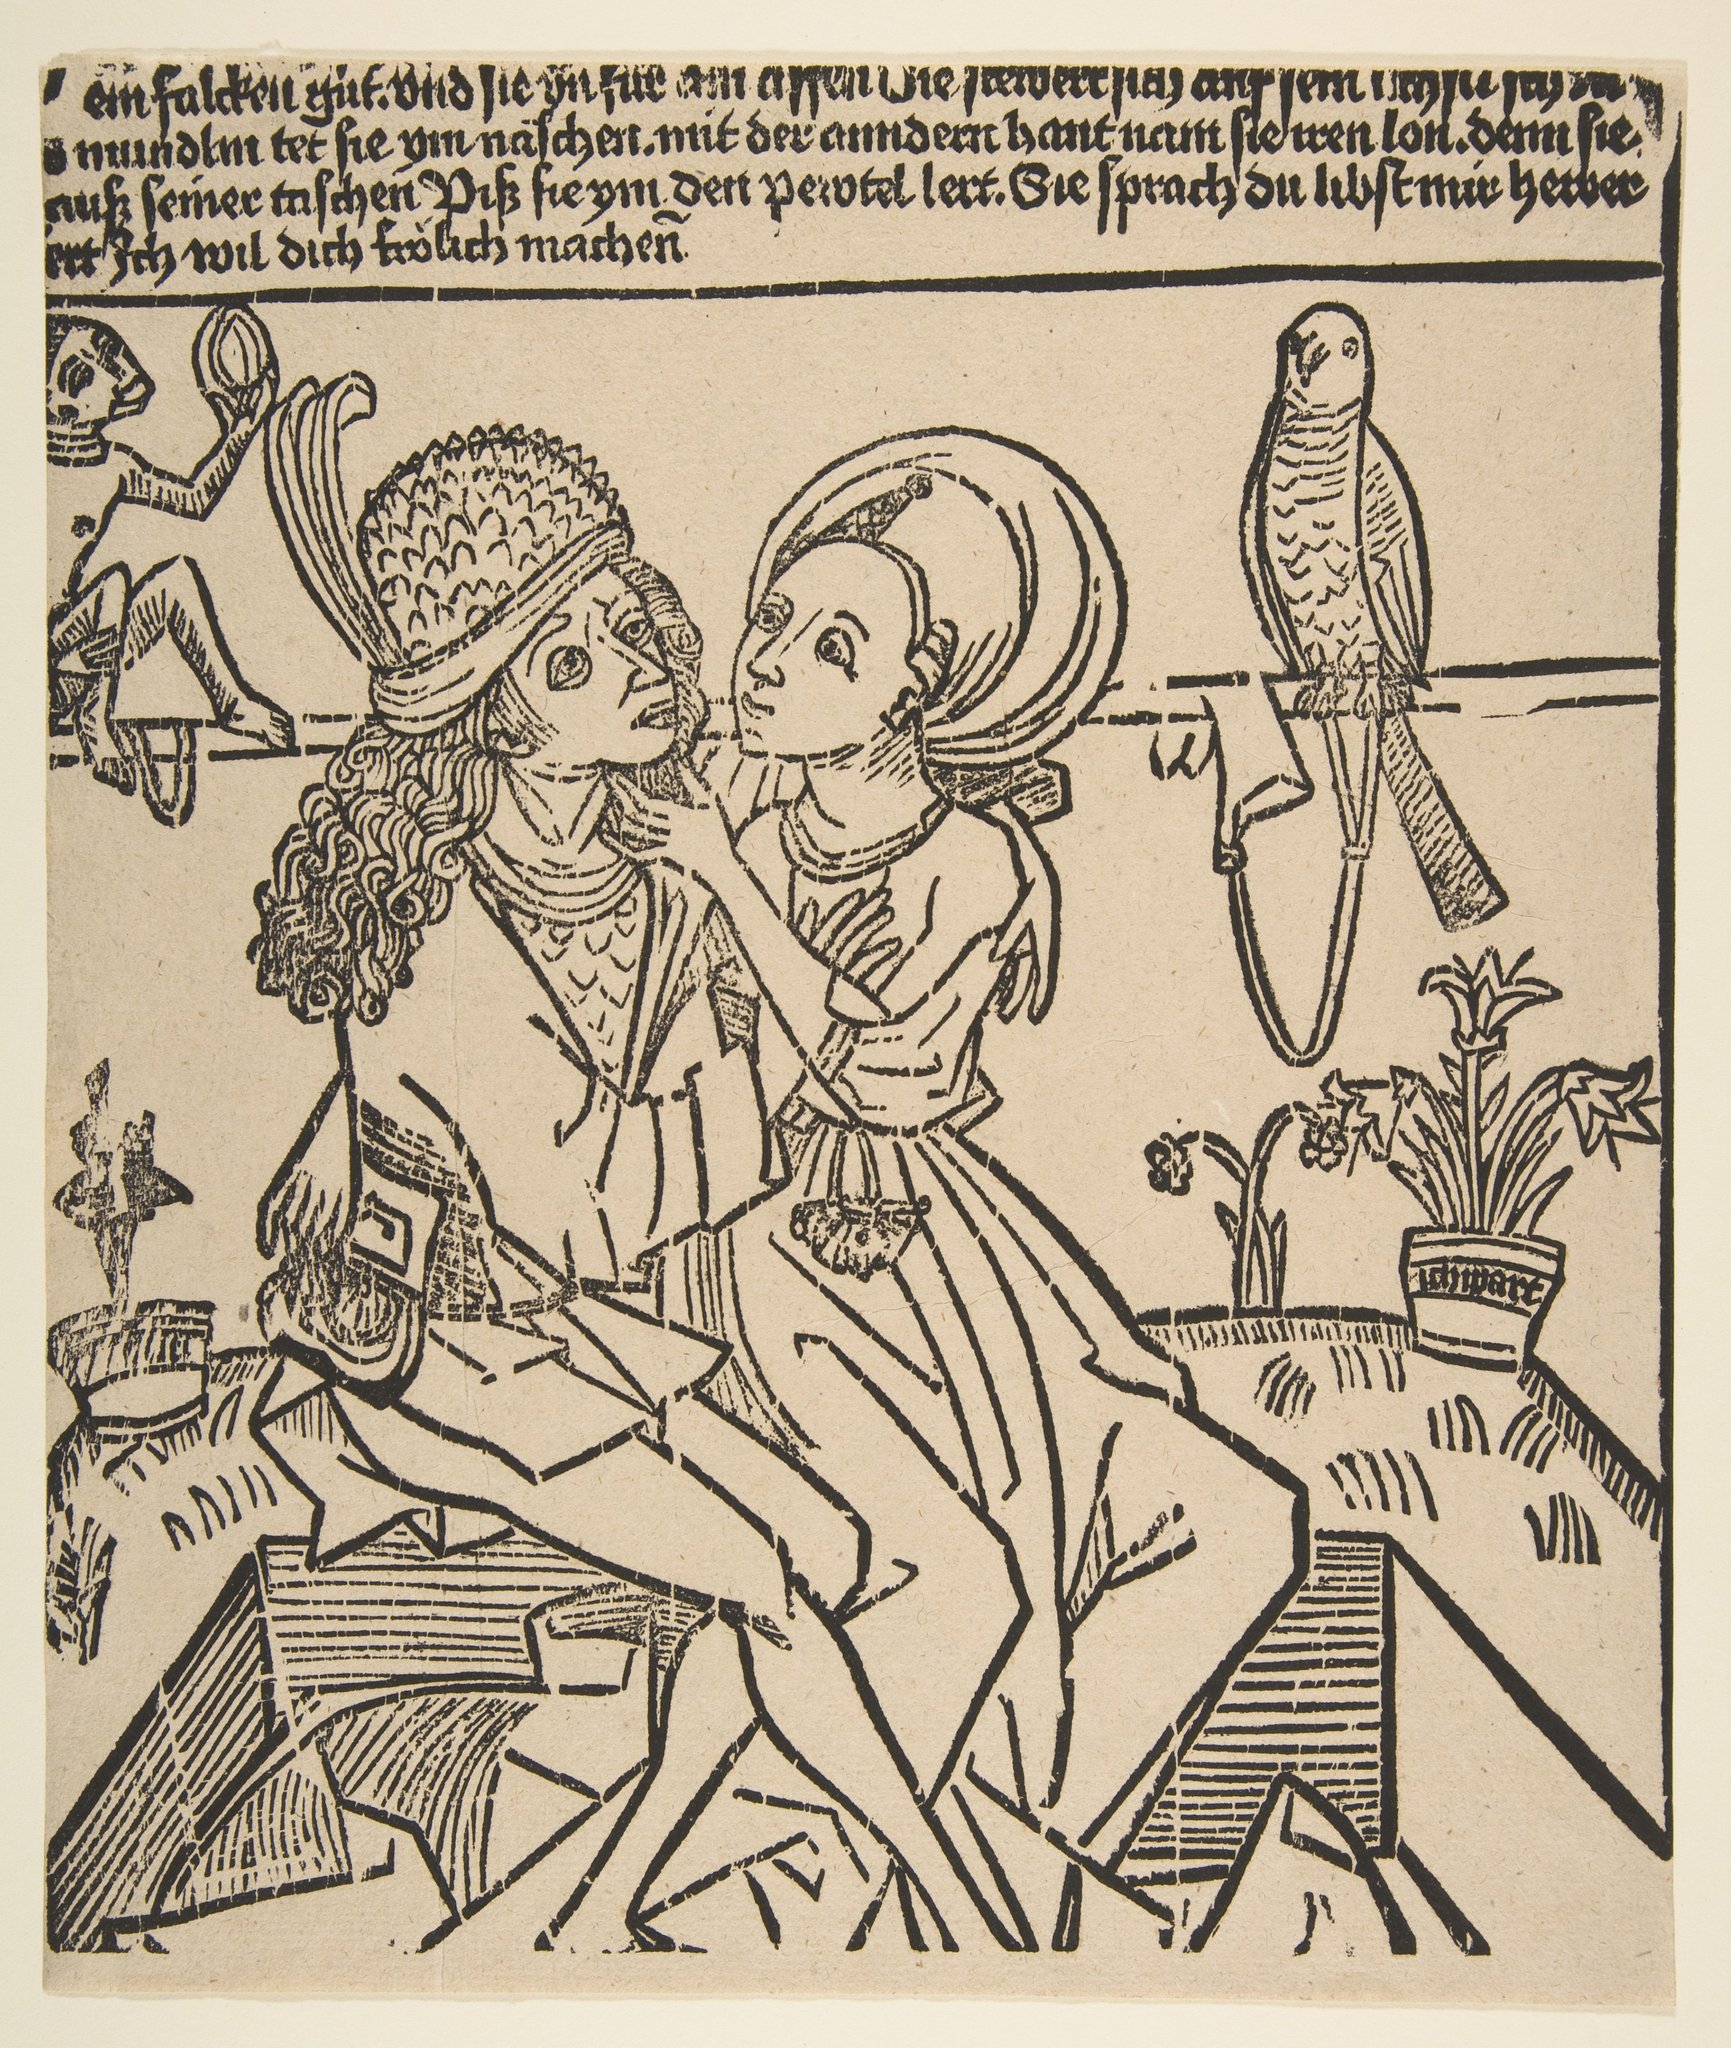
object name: print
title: Lovers (Schr. 1976)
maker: anonymous, german, 15th century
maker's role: artist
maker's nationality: german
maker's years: 1400-1500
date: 1401-1500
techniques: woodcut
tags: birds,lovers